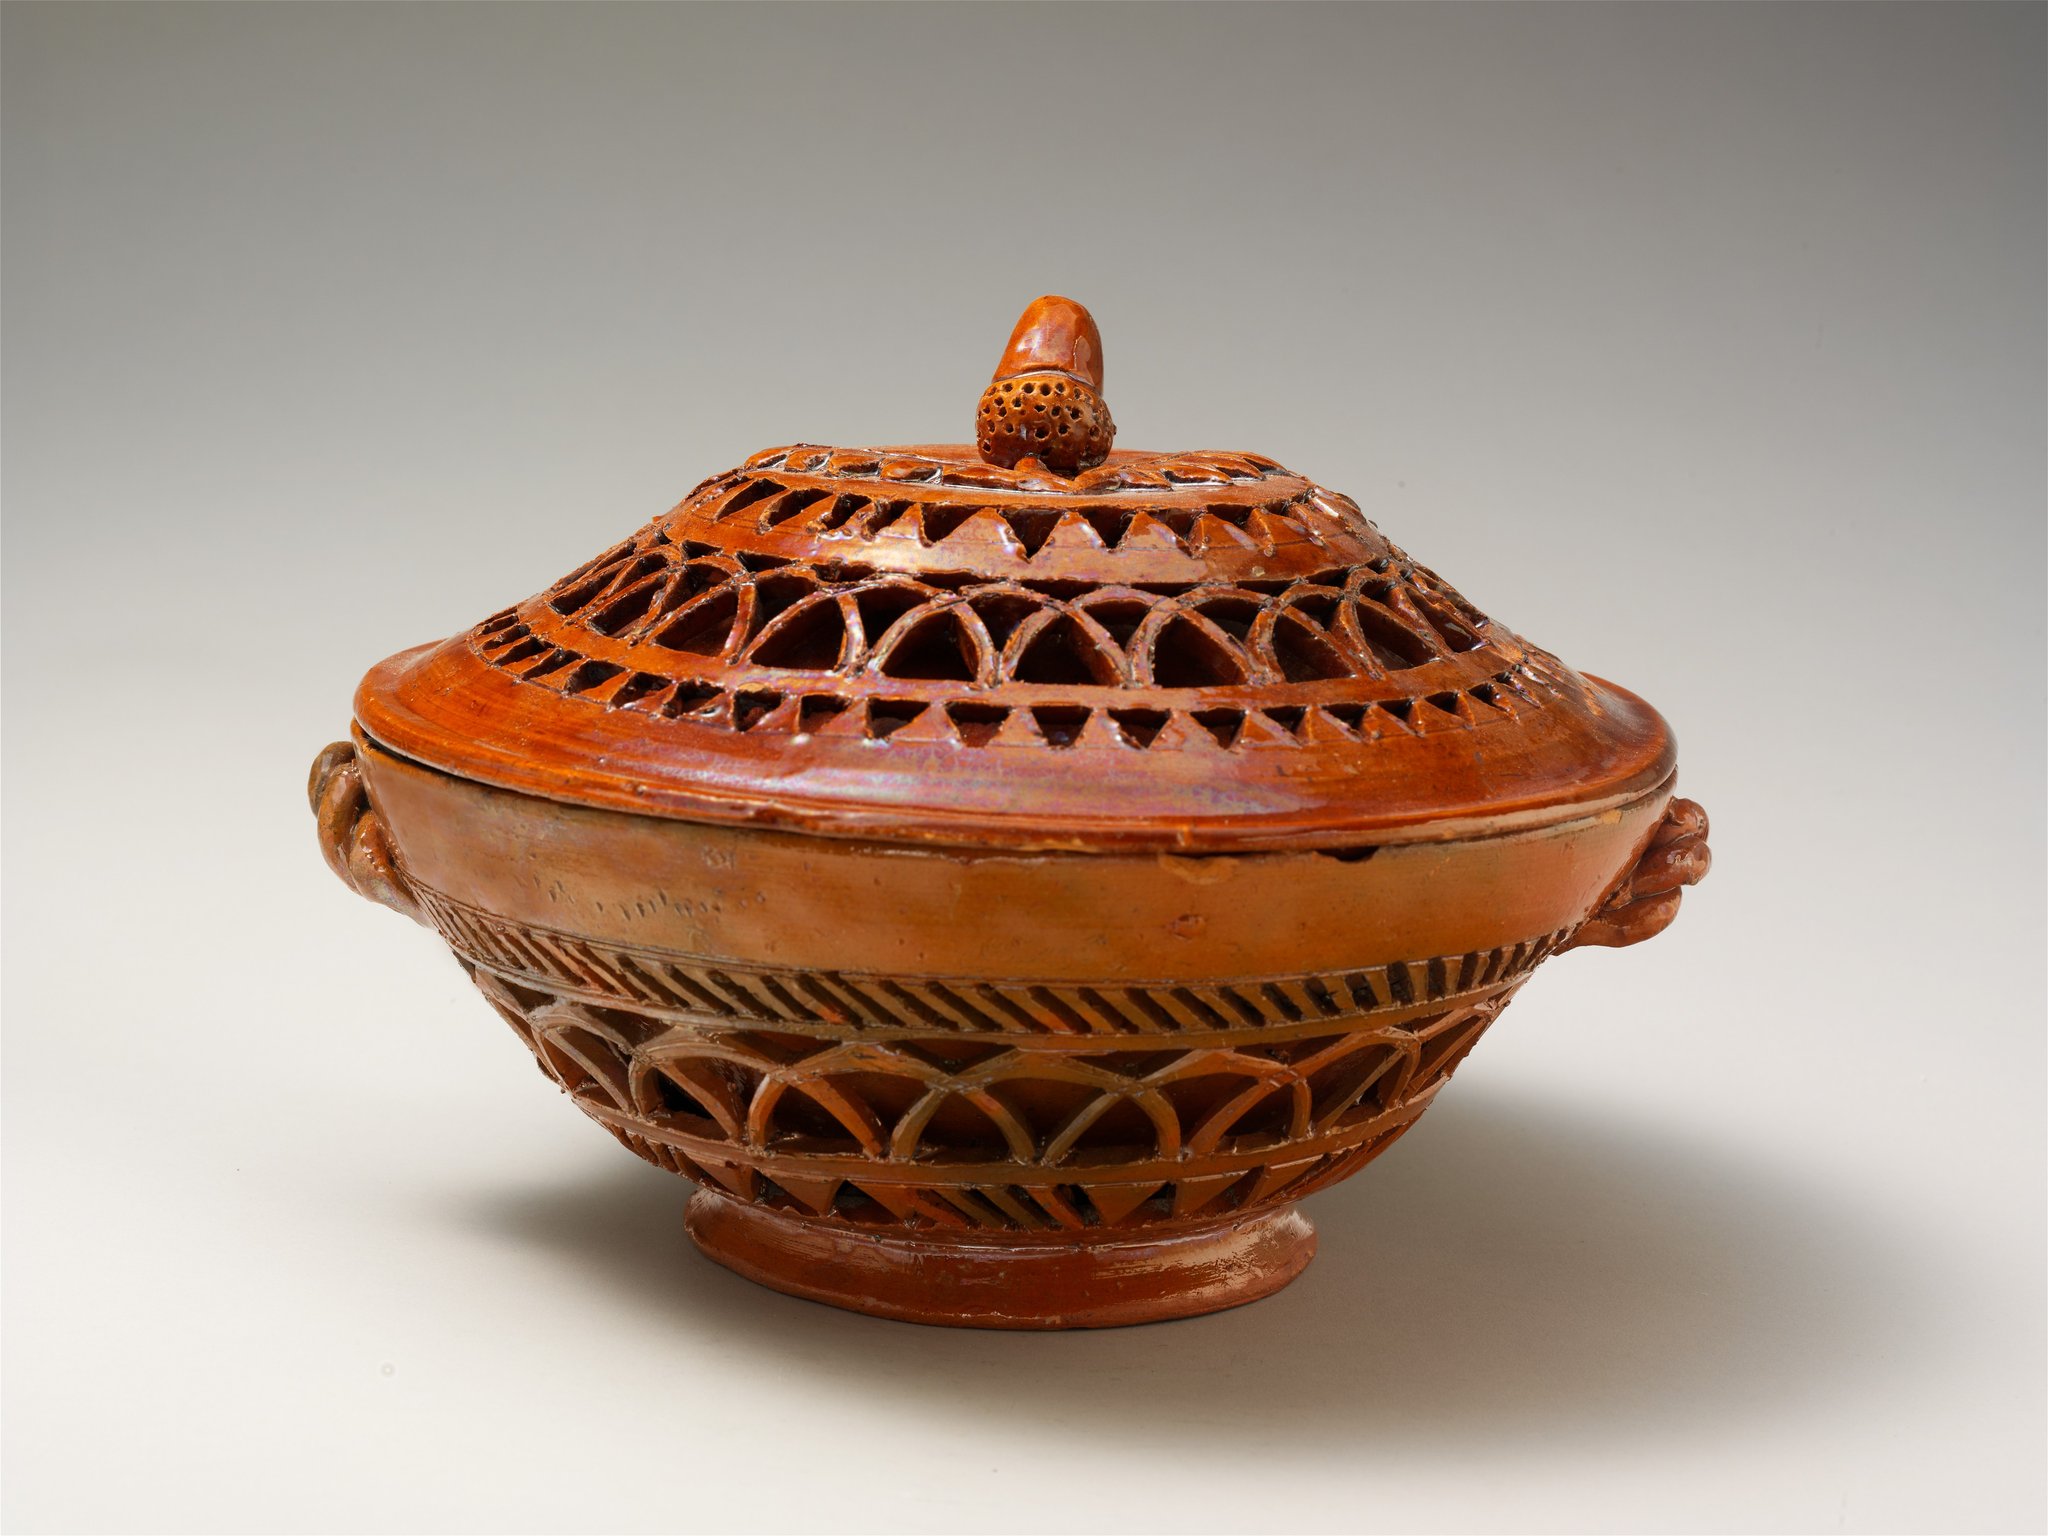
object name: bowl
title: Covered bowl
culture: american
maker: david haring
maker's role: maker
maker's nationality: american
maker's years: 1801-1871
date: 1830-1840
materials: earthenware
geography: united states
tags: acorns